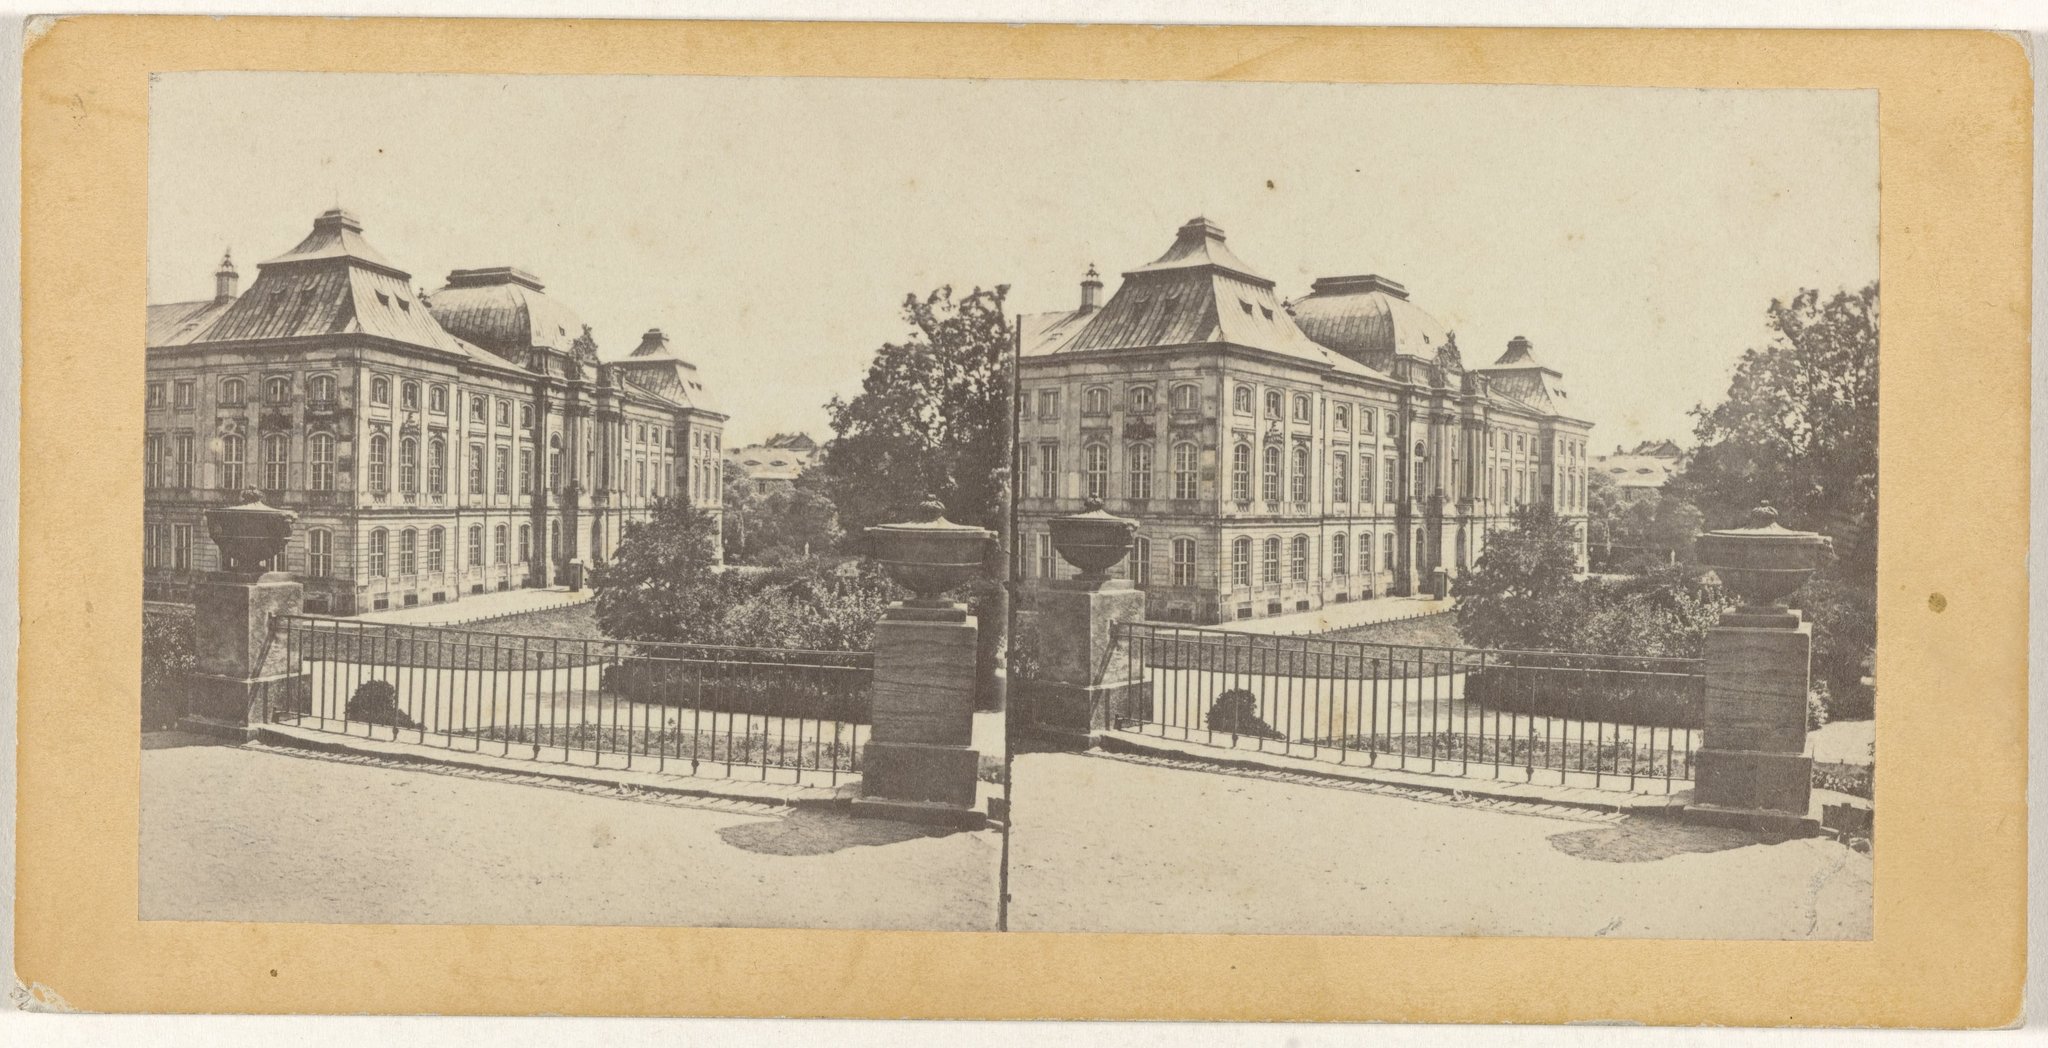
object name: stereograph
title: Gezicht op het Japanse Paleis in Dresden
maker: Anonymous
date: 1852-1863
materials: cardboard, paper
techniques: albumen print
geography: dresden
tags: palace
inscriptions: inscription: ‘Mr’, number: ‘202’, inscription: ‘H’, inscription: ‘nj’